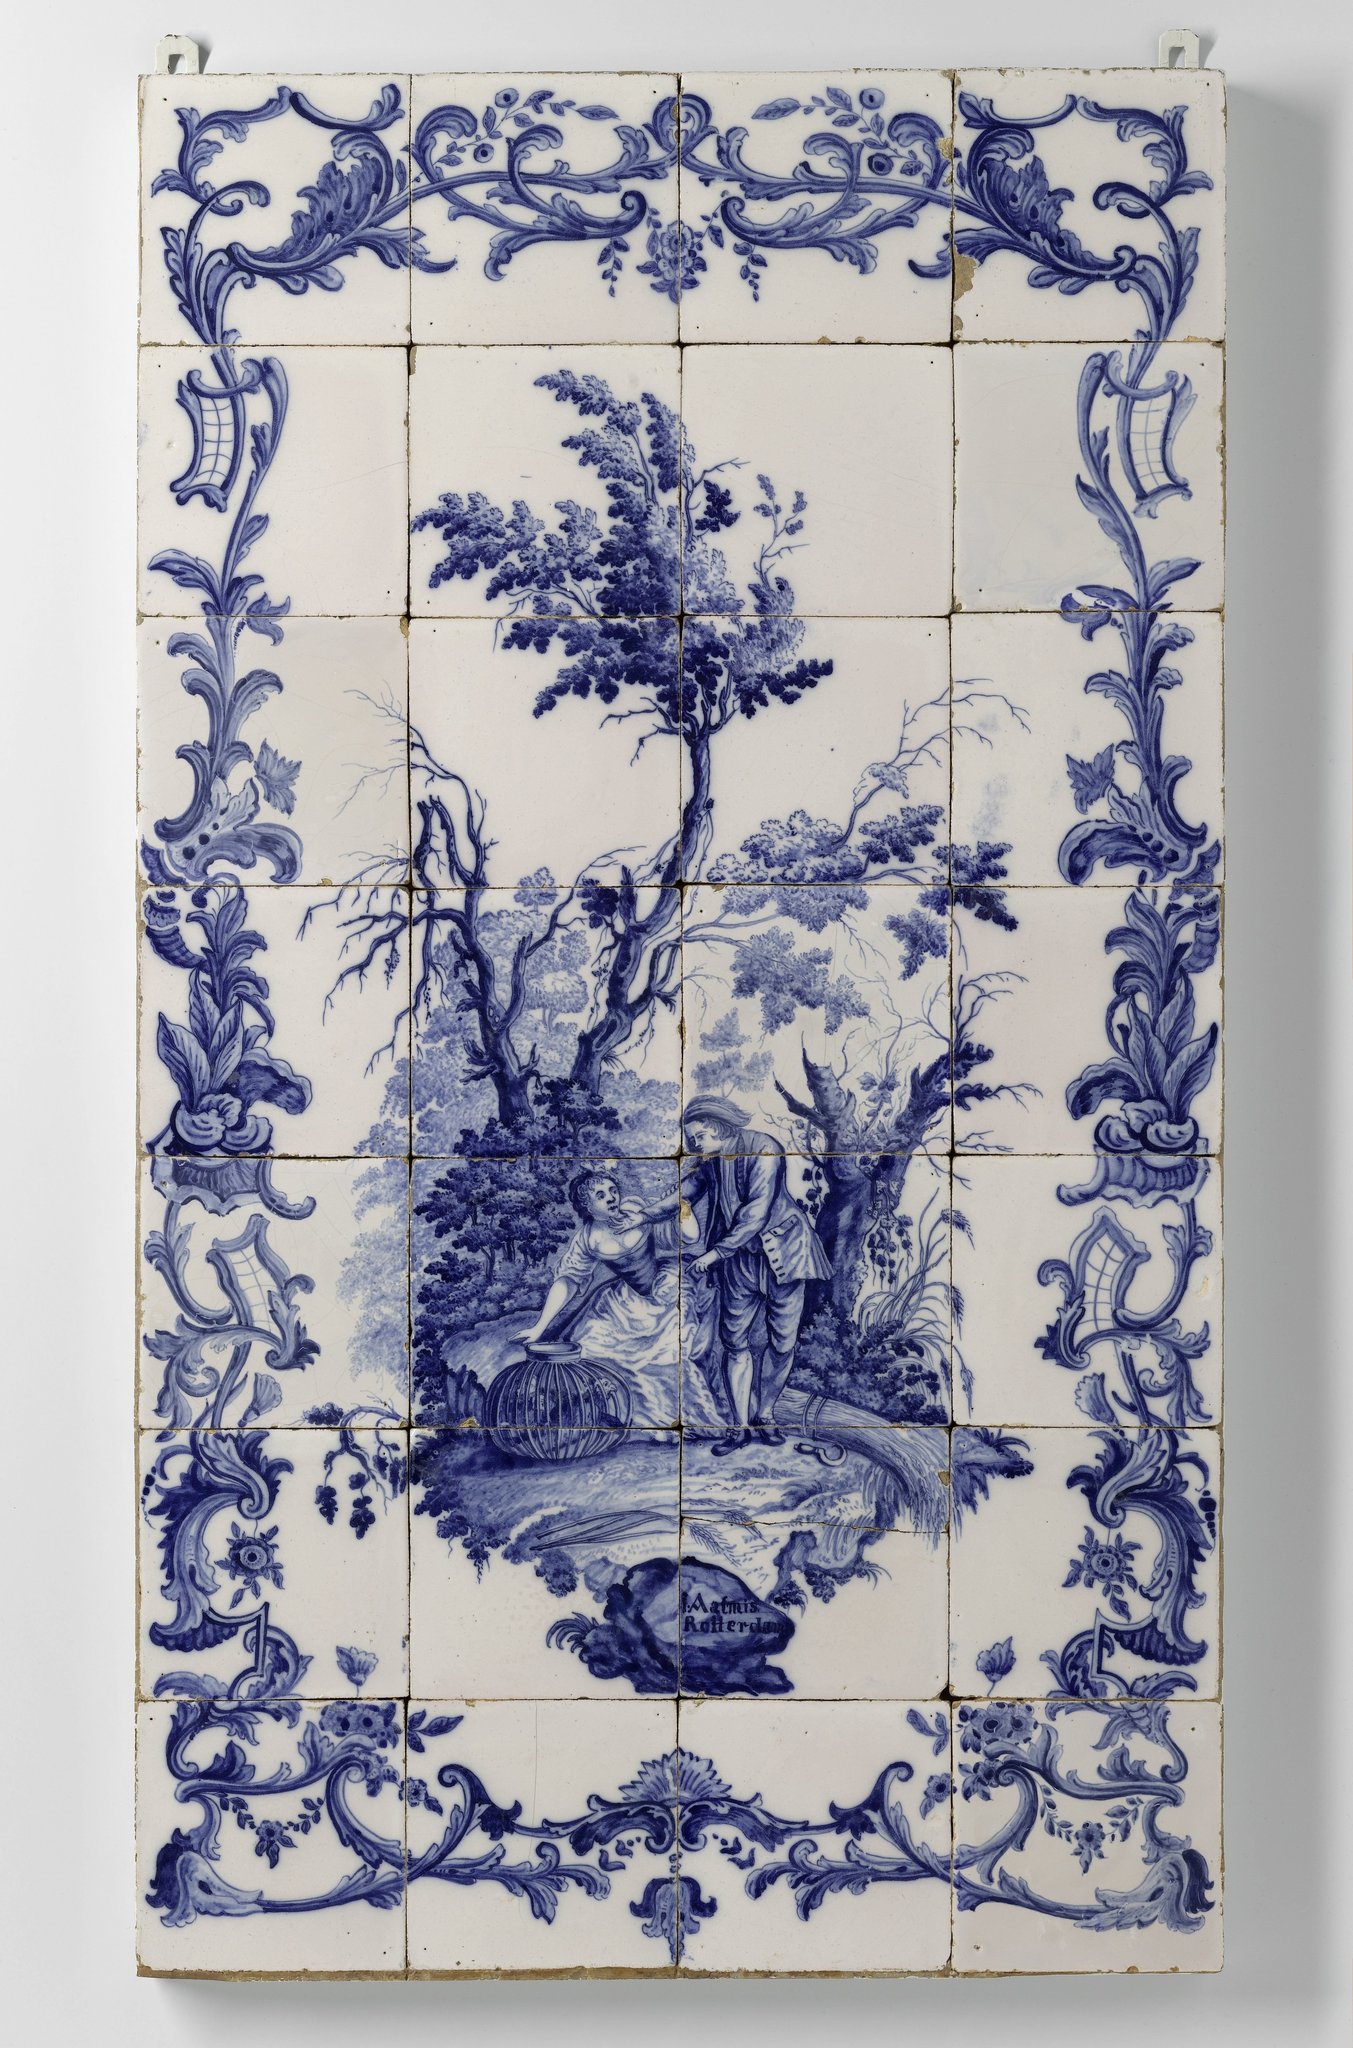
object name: tile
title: Three tile panels with Autumn, Summer and Spring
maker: johannes aelmis (i)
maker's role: tegelschilder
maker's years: 1674-1755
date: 1760-1780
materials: earthenware, glaze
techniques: maiolica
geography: rotterdam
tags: summer ~ human activities (the four seasons of the year)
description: Couples with individual attributes represent three of the four seasons. An elegant, Rococo border frames the scenes. The panels probably come from a room once decorated with tiles.